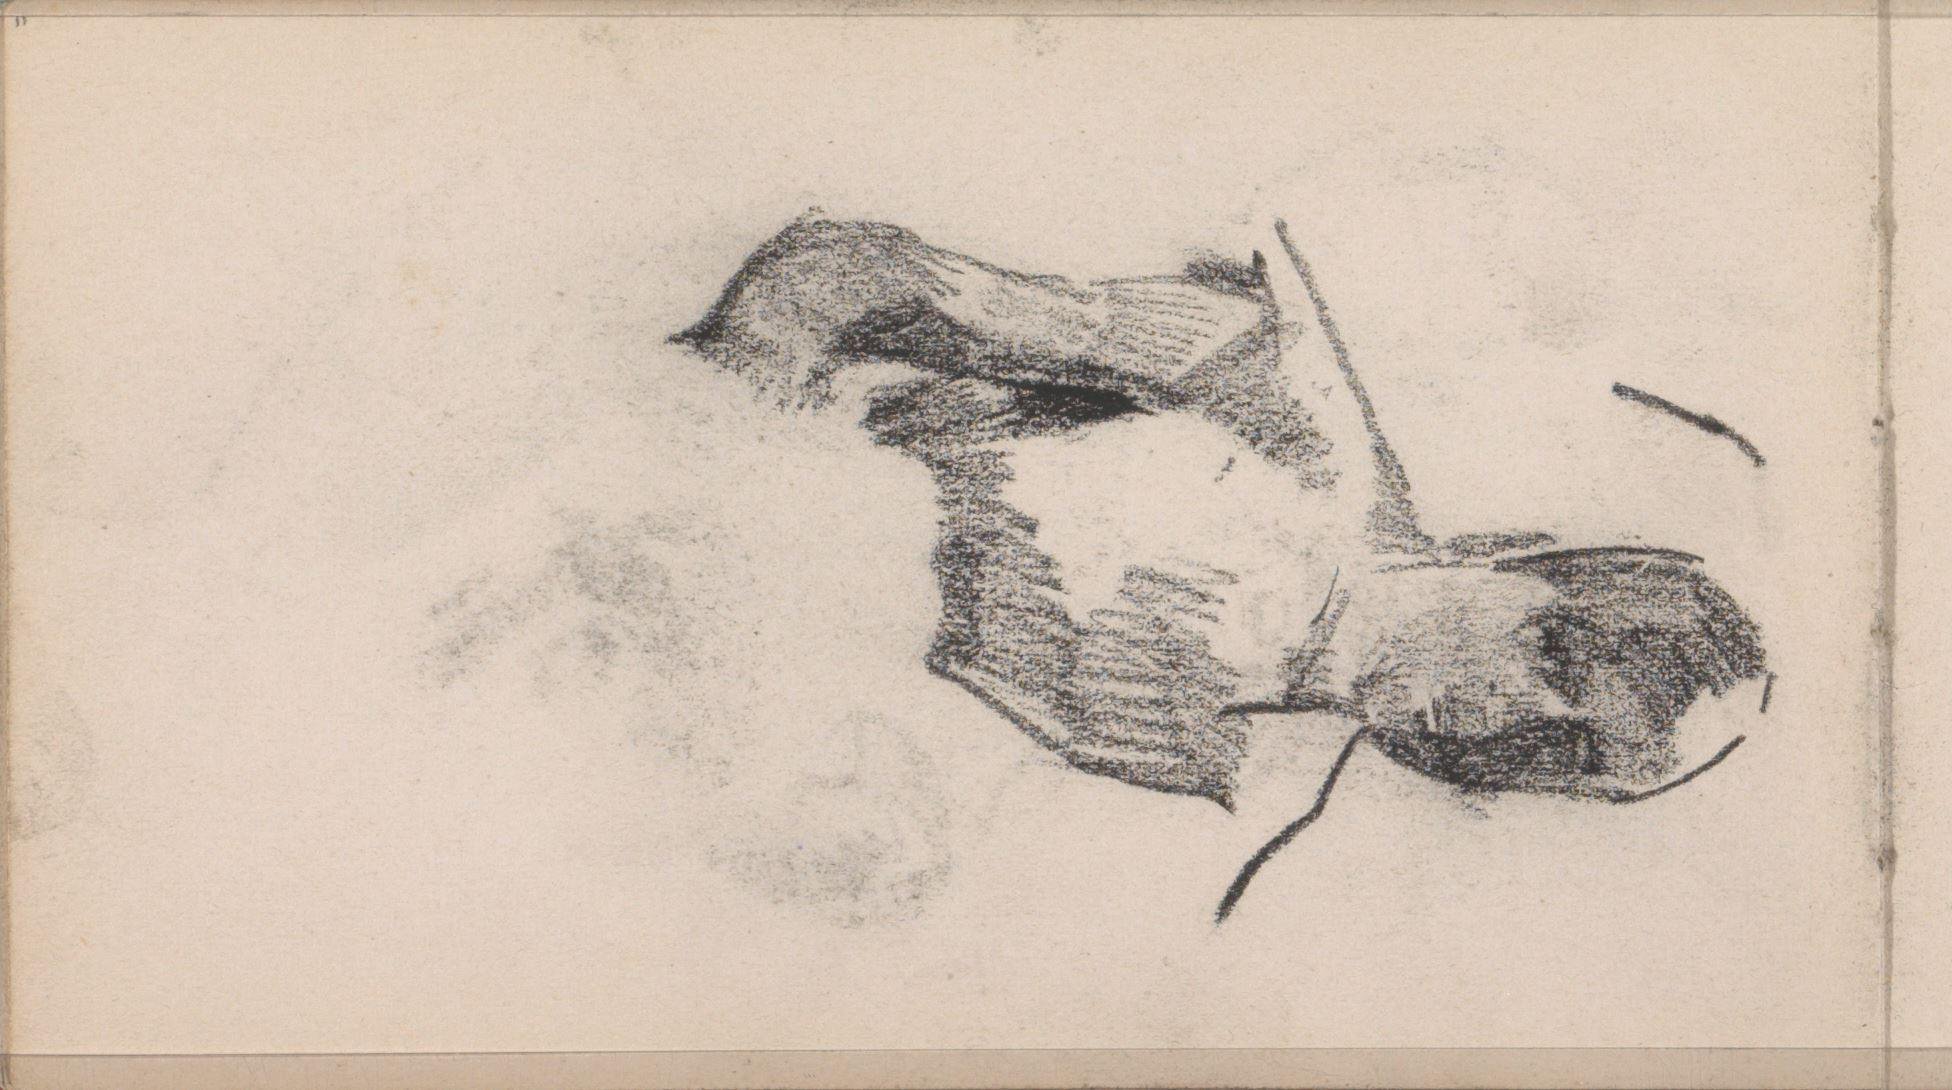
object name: sketchbook leaf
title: Figuurstudie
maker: george hendrik breitner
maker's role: draughtsman, painter, print maker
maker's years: 1857-1923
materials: chalk, paper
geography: amsterdam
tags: adult woman, adult man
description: Pagina 11 uit een schetsboek met 32 bladen.